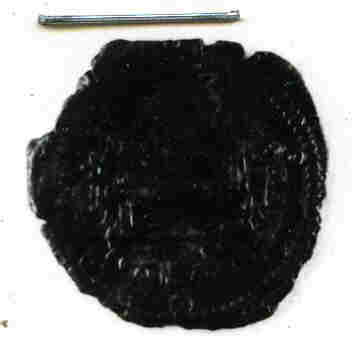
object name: coin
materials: copper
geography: iran